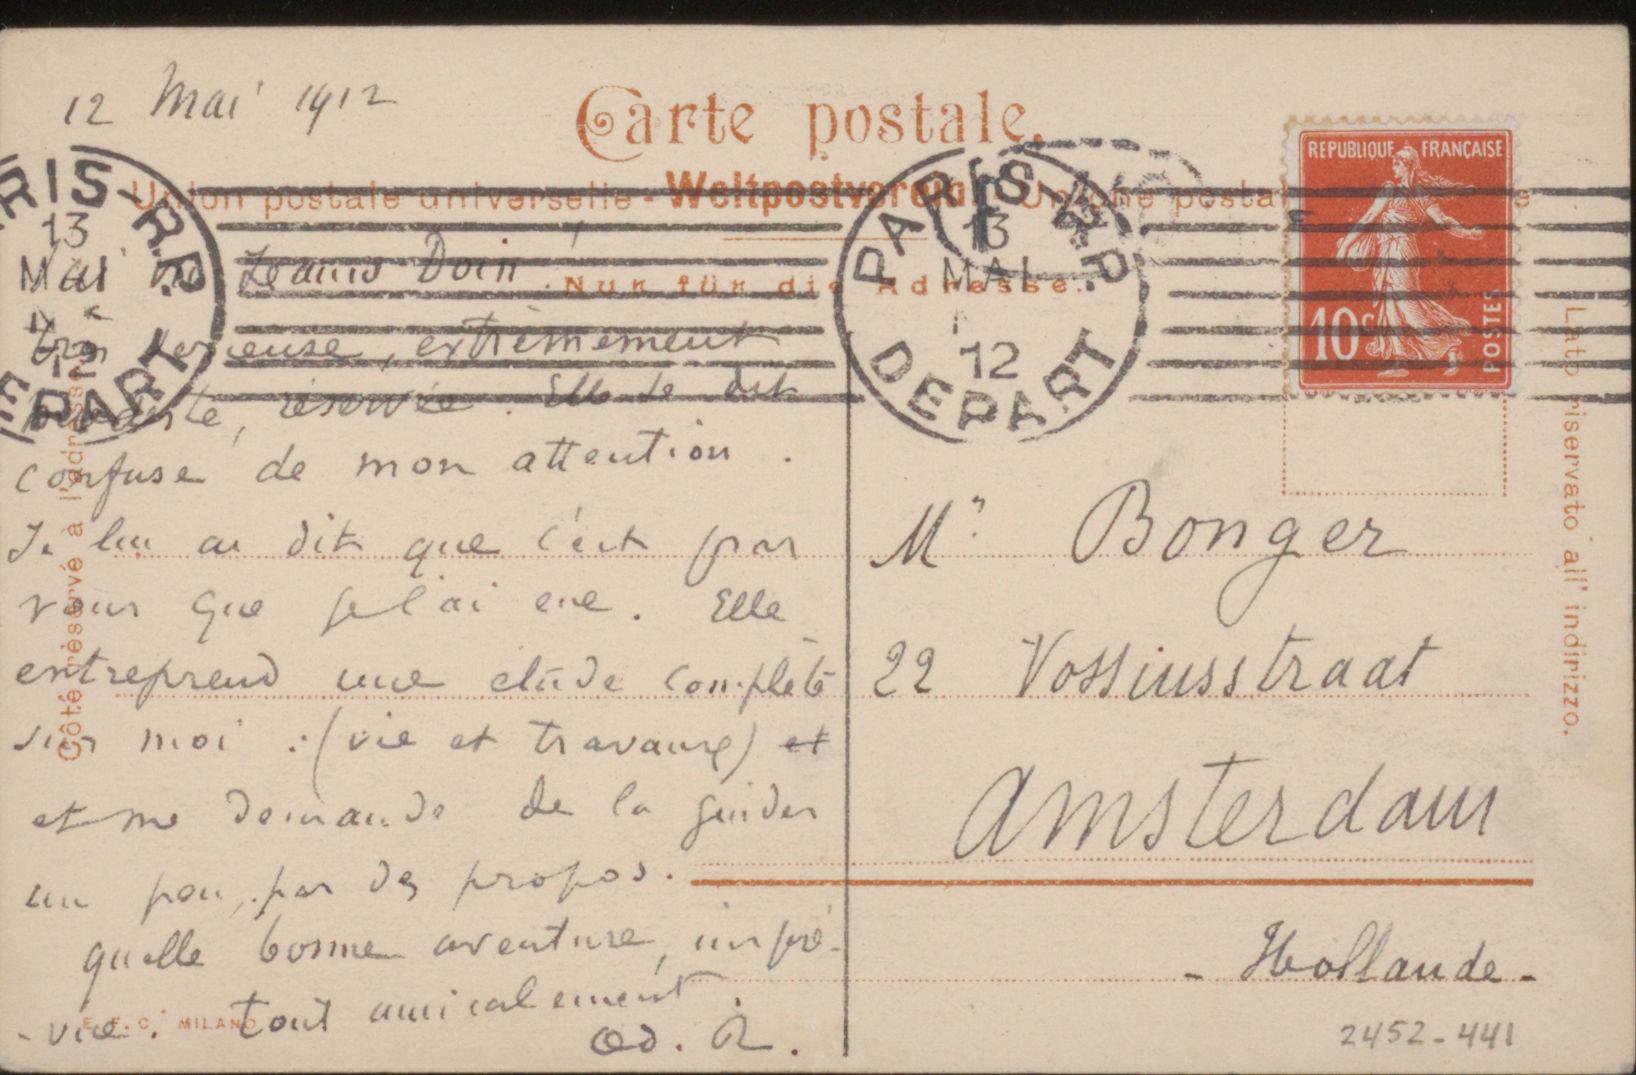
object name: ansichtkaart, prentbriefkaart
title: Prentbriefkaart aan Andries Bonger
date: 1912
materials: cardboard, ink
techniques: photograph, pen, writing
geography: venice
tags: amsterdam, andries bonger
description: Prentbriefkaart behoort tot een album samengesteld door weduwe Françoise W.M. Barones van der Borch van Verwolde met afschriften van brieven met betrekking tot (de familie van) Odilon Redon. De prentbriefkaart werd bewaard op pagina 189.